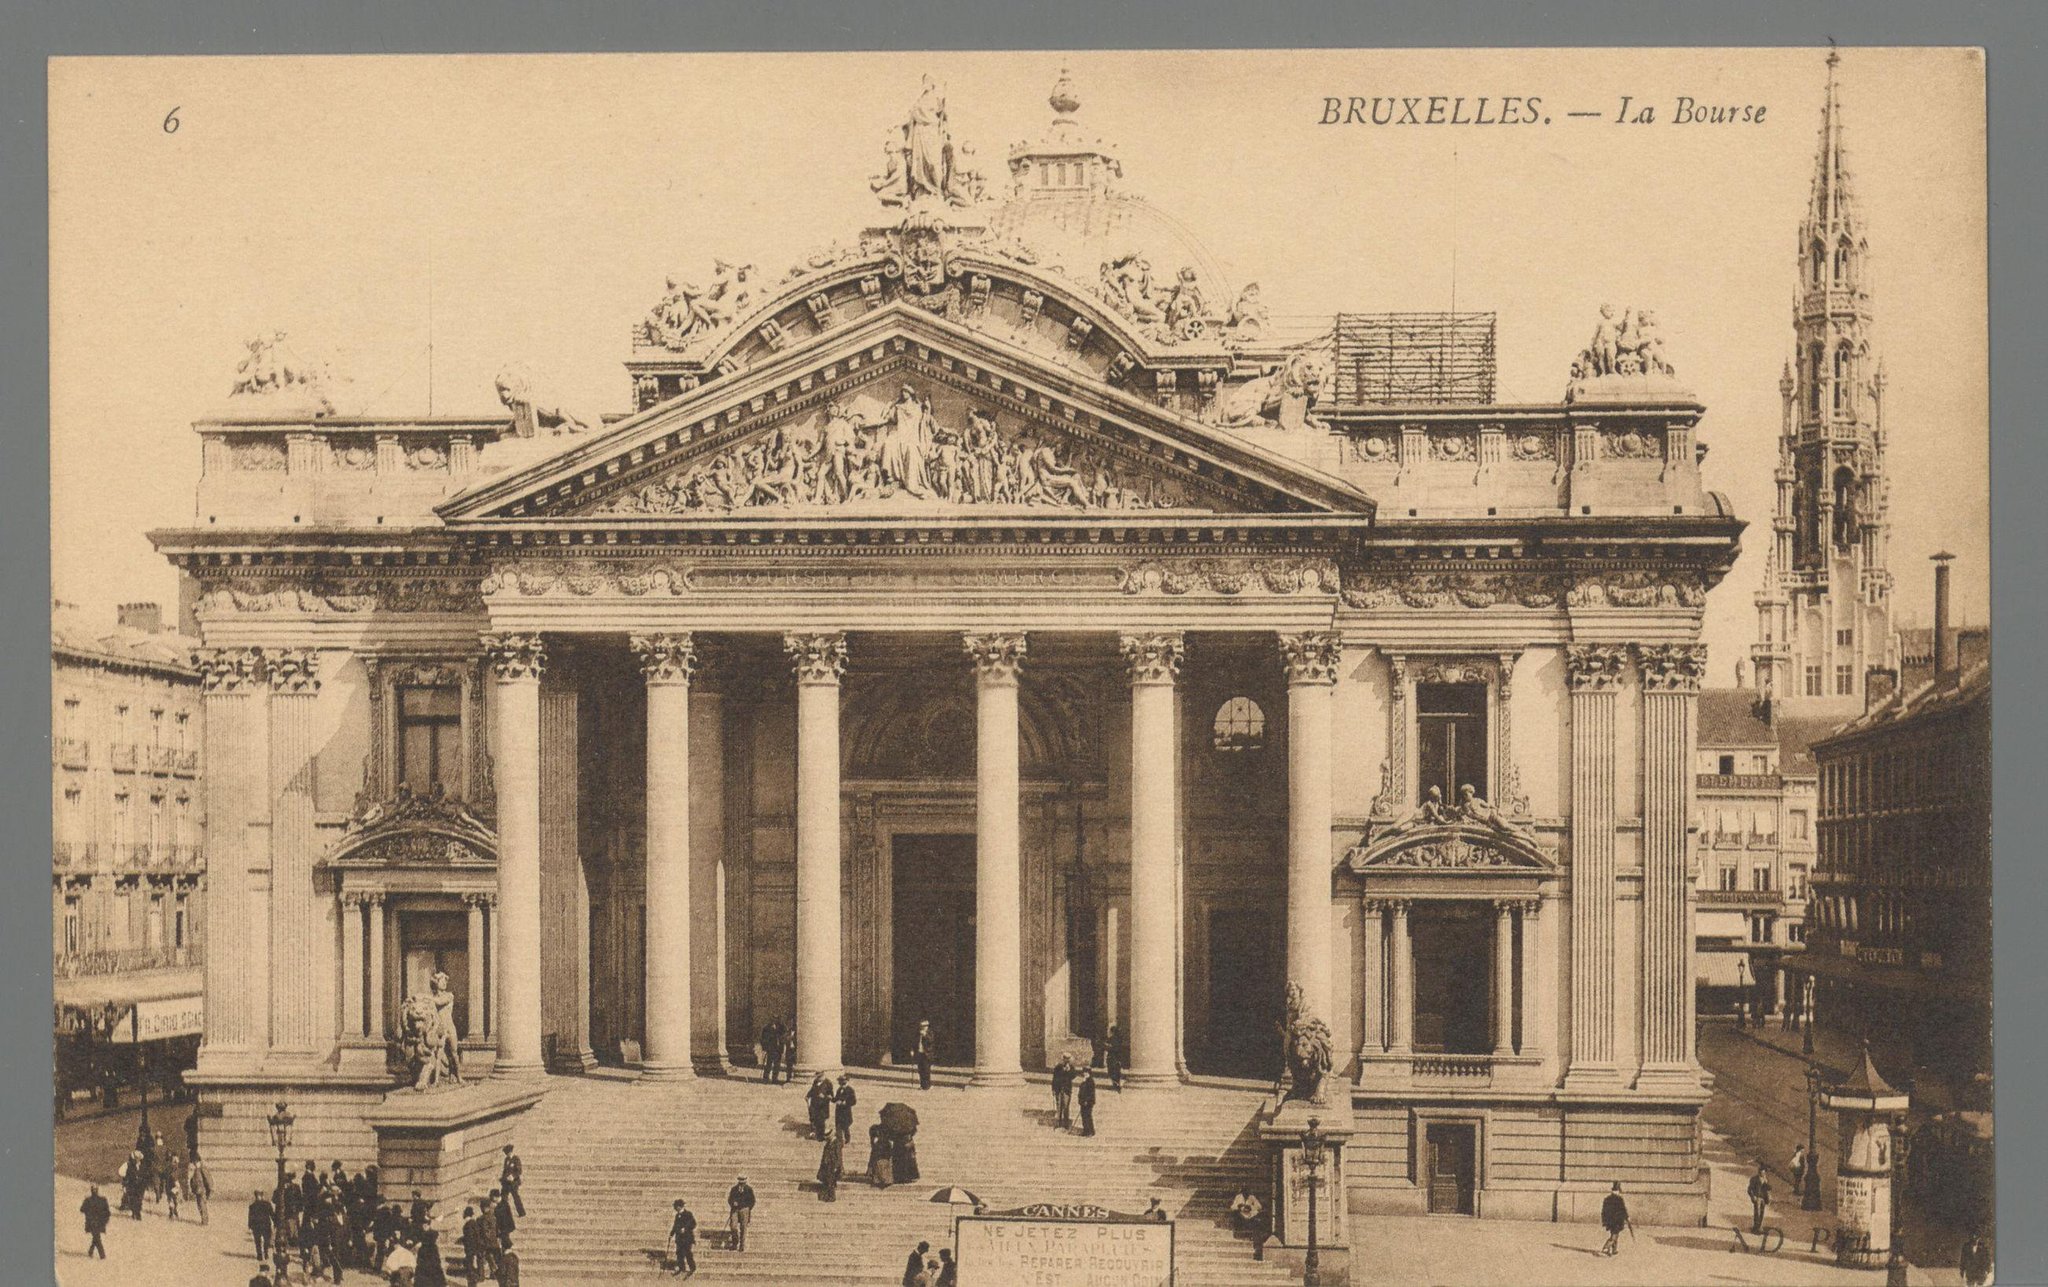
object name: photomechanical print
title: Bruxelles. La Bourse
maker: Anonymous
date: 1906-1918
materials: cardboard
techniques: photograph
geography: brussels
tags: exchange, bourse, city-view, and landscape with man-made constructions (+ city(-scape) with figures, staffage)